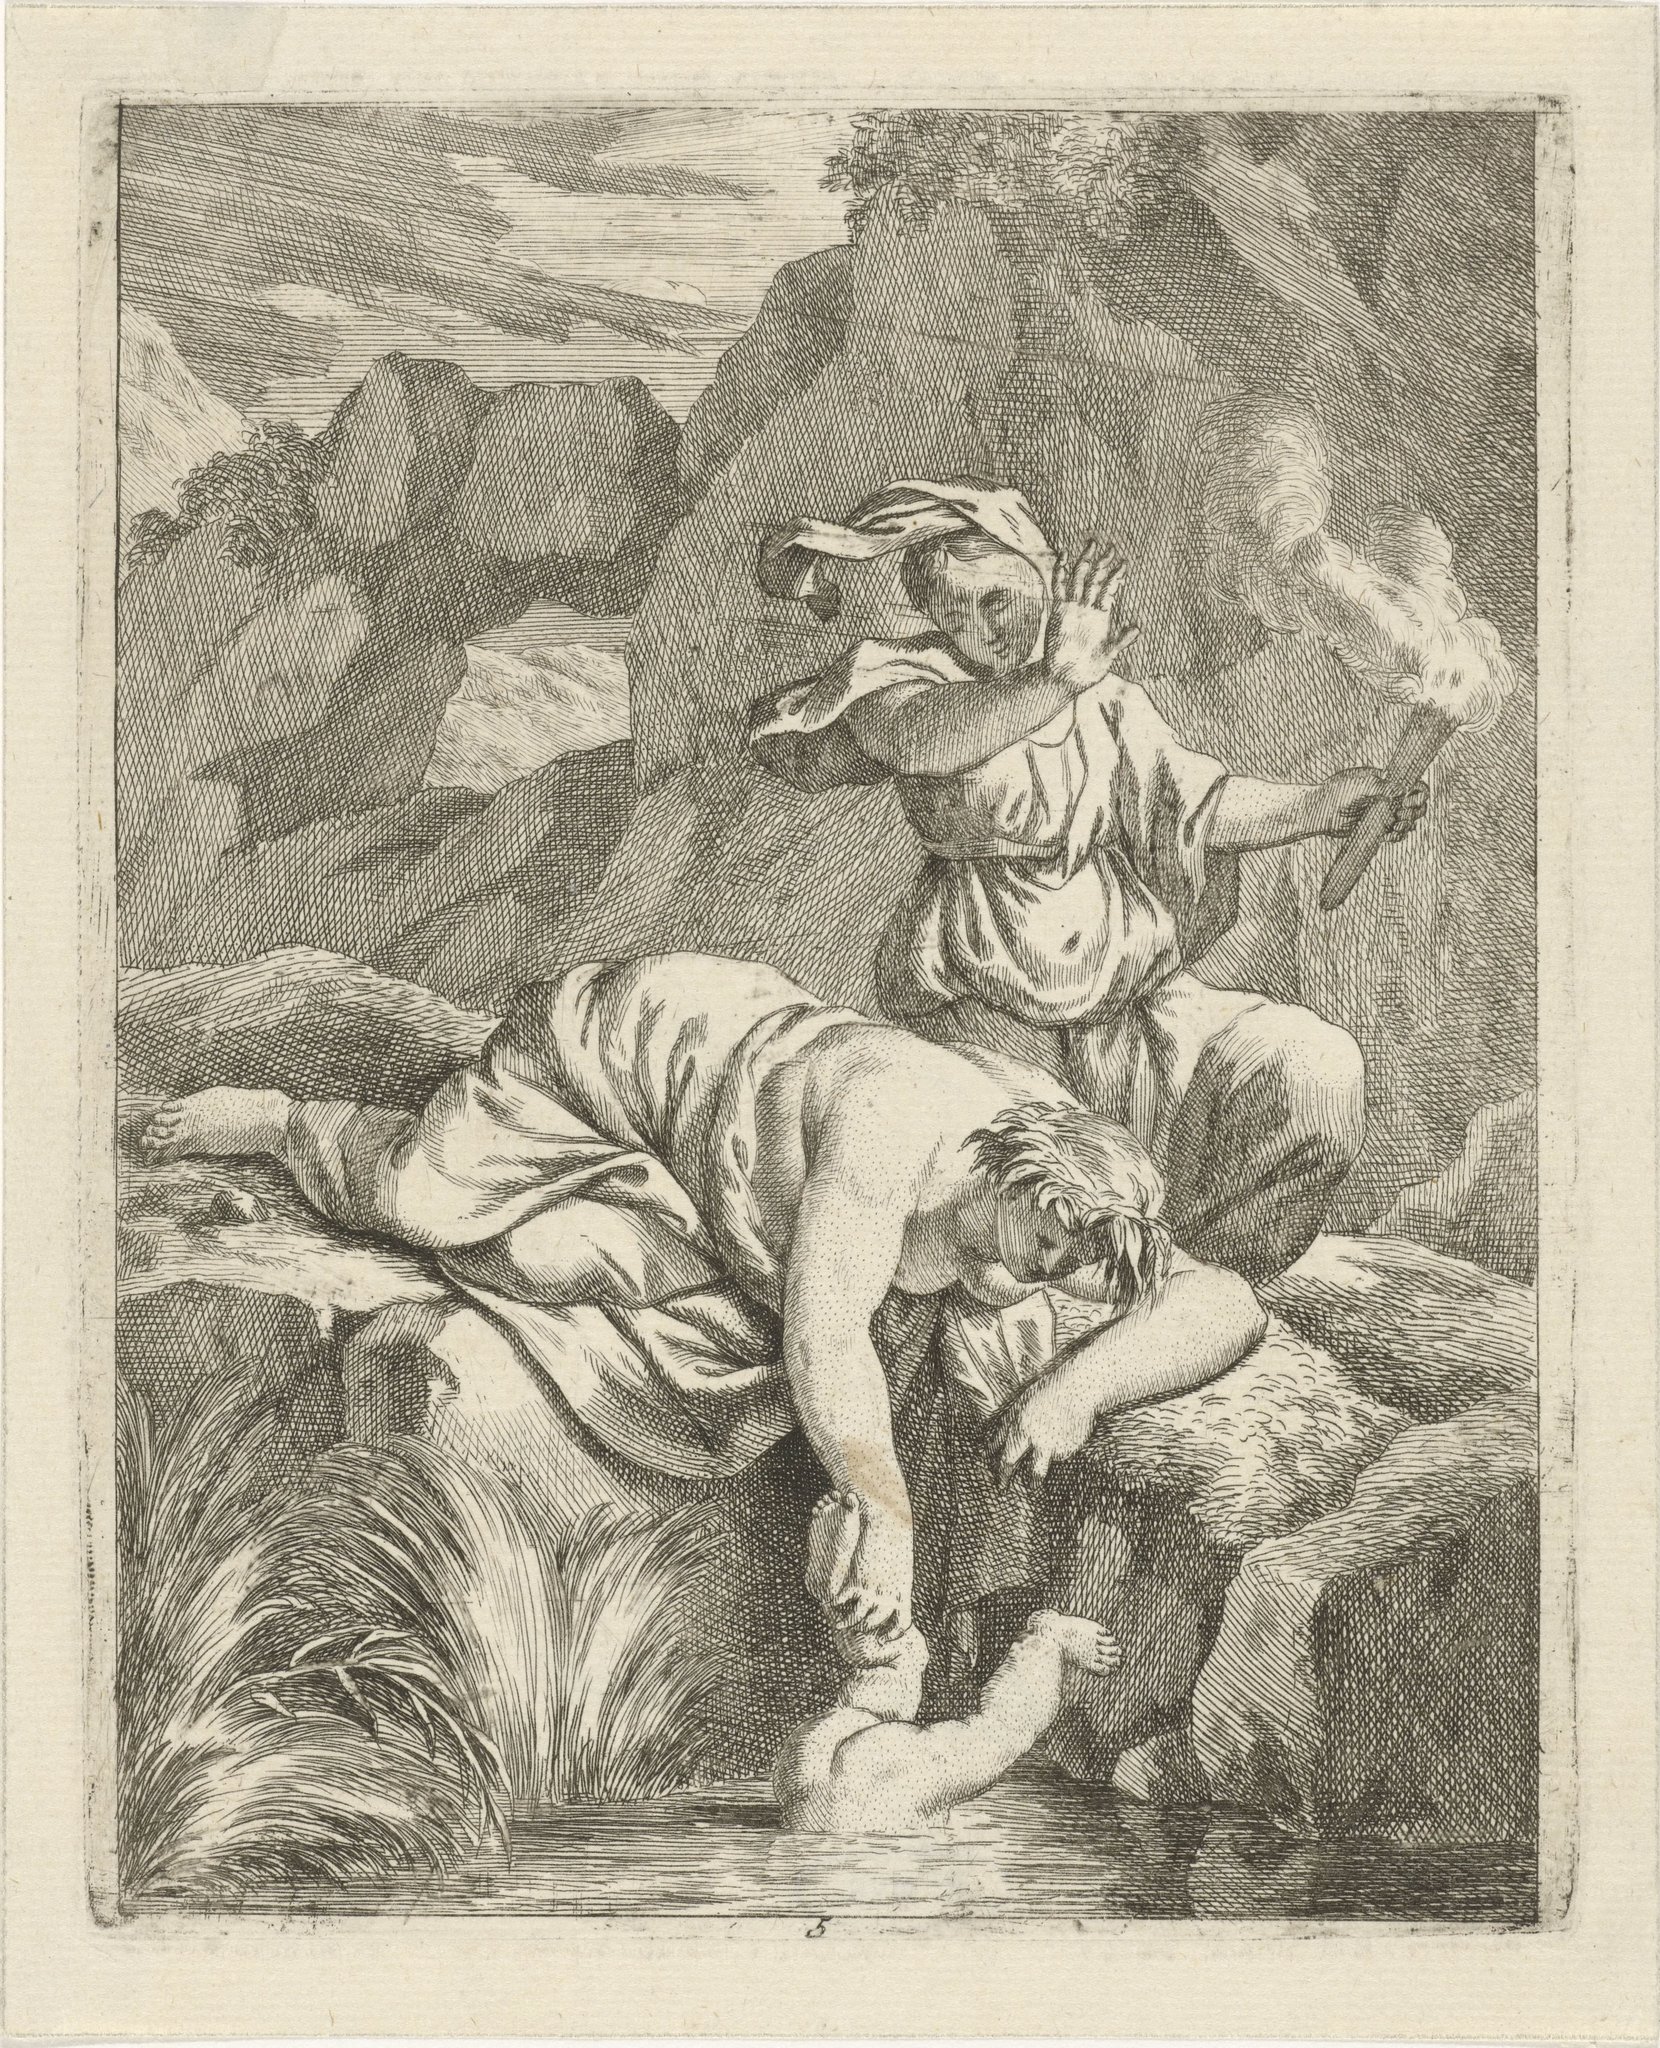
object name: print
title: Vitam et mortem achilli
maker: j. alexander janssens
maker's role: print maker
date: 1700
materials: paper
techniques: engraving, etching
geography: southern netherlands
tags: thetis dips achilles in the styx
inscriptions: collector's mark: Lugt 2228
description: Rotslandschap met Thetis die Achilles onderdompelt in de Styx. Thetis ligt op een rots en achter haar staat een vrouw met een brandende fakkel. Midden onder: 5. Vijfde prent uit een serie van veertien met scènes uit het leven van Achilles.